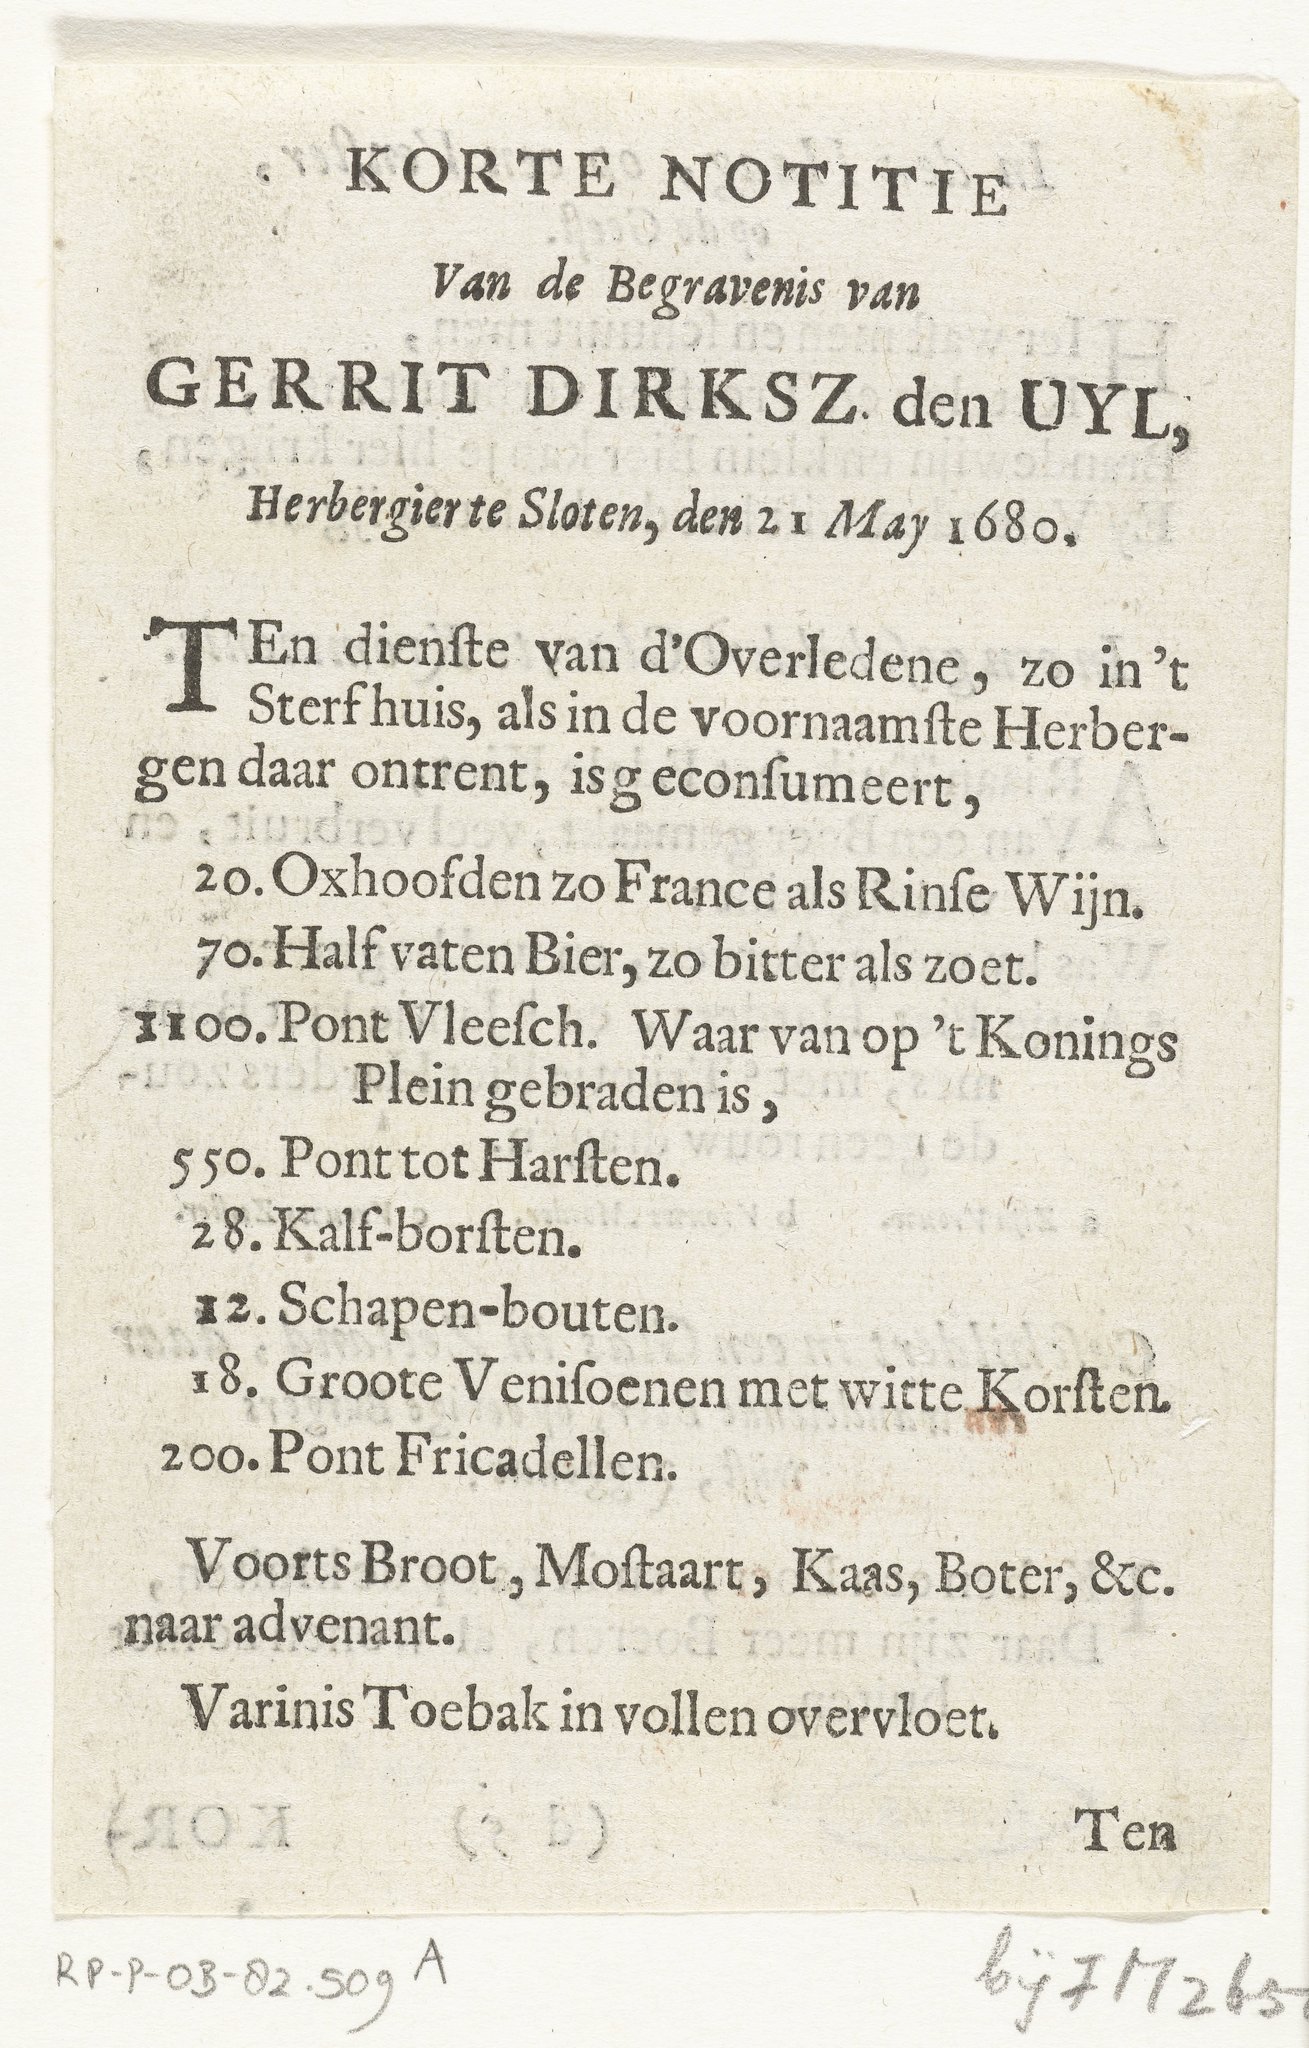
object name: text sheet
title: Korte Notitie Van de Begravenis van Gerrit Dirksz. den Uyl, Herbergier te Sloten, den 21 May 1680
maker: Anonymous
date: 1680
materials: paper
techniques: letterpress printing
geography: northern netherlands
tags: herbergier, gerrit dirksz. den uyl, sloten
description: Tekstblad met beschrijving van het feestmaal bij de begrafenis van Gerrit Dirksz. den Uyl, herbergier te Sloten, 22 mei 1680. Lijst van de hoeveelheden gegeten en gedronken spijzen en dranken.